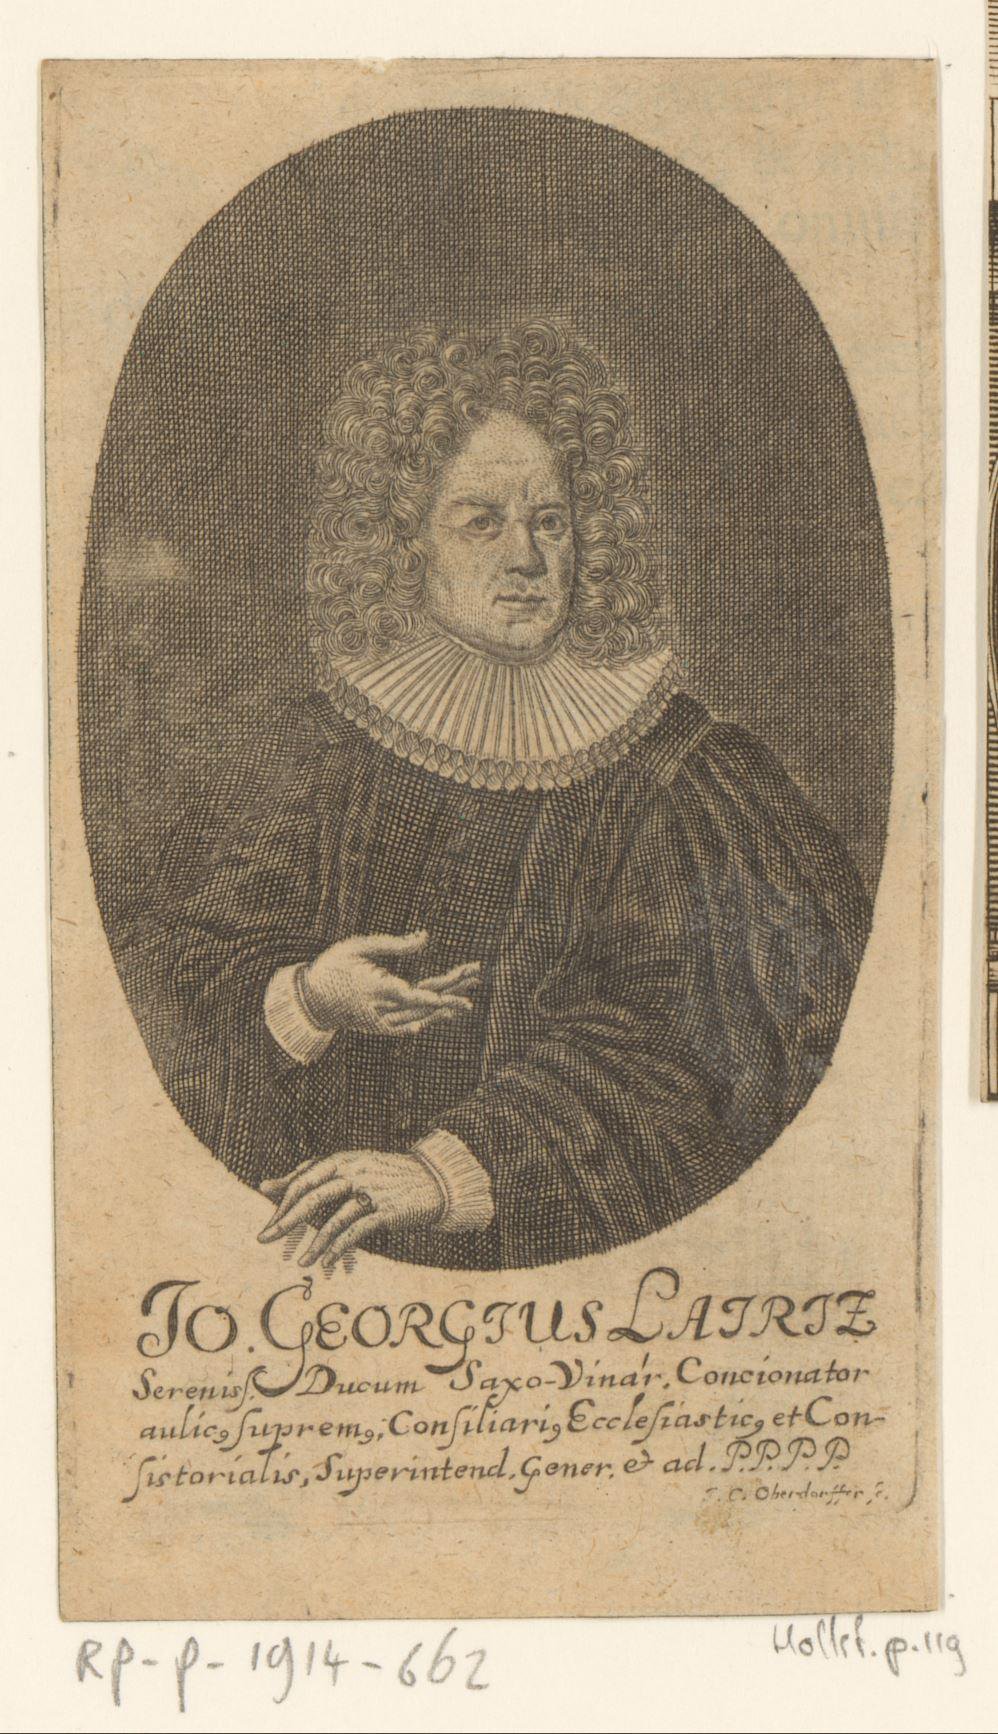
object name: print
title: Portret van Johann Georg Lairitz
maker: johann christoph oberdörffer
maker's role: print maker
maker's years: 1664-1724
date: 1679-1724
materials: paper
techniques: engraving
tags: historical persons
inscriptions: collector's mark: Lugt 2228